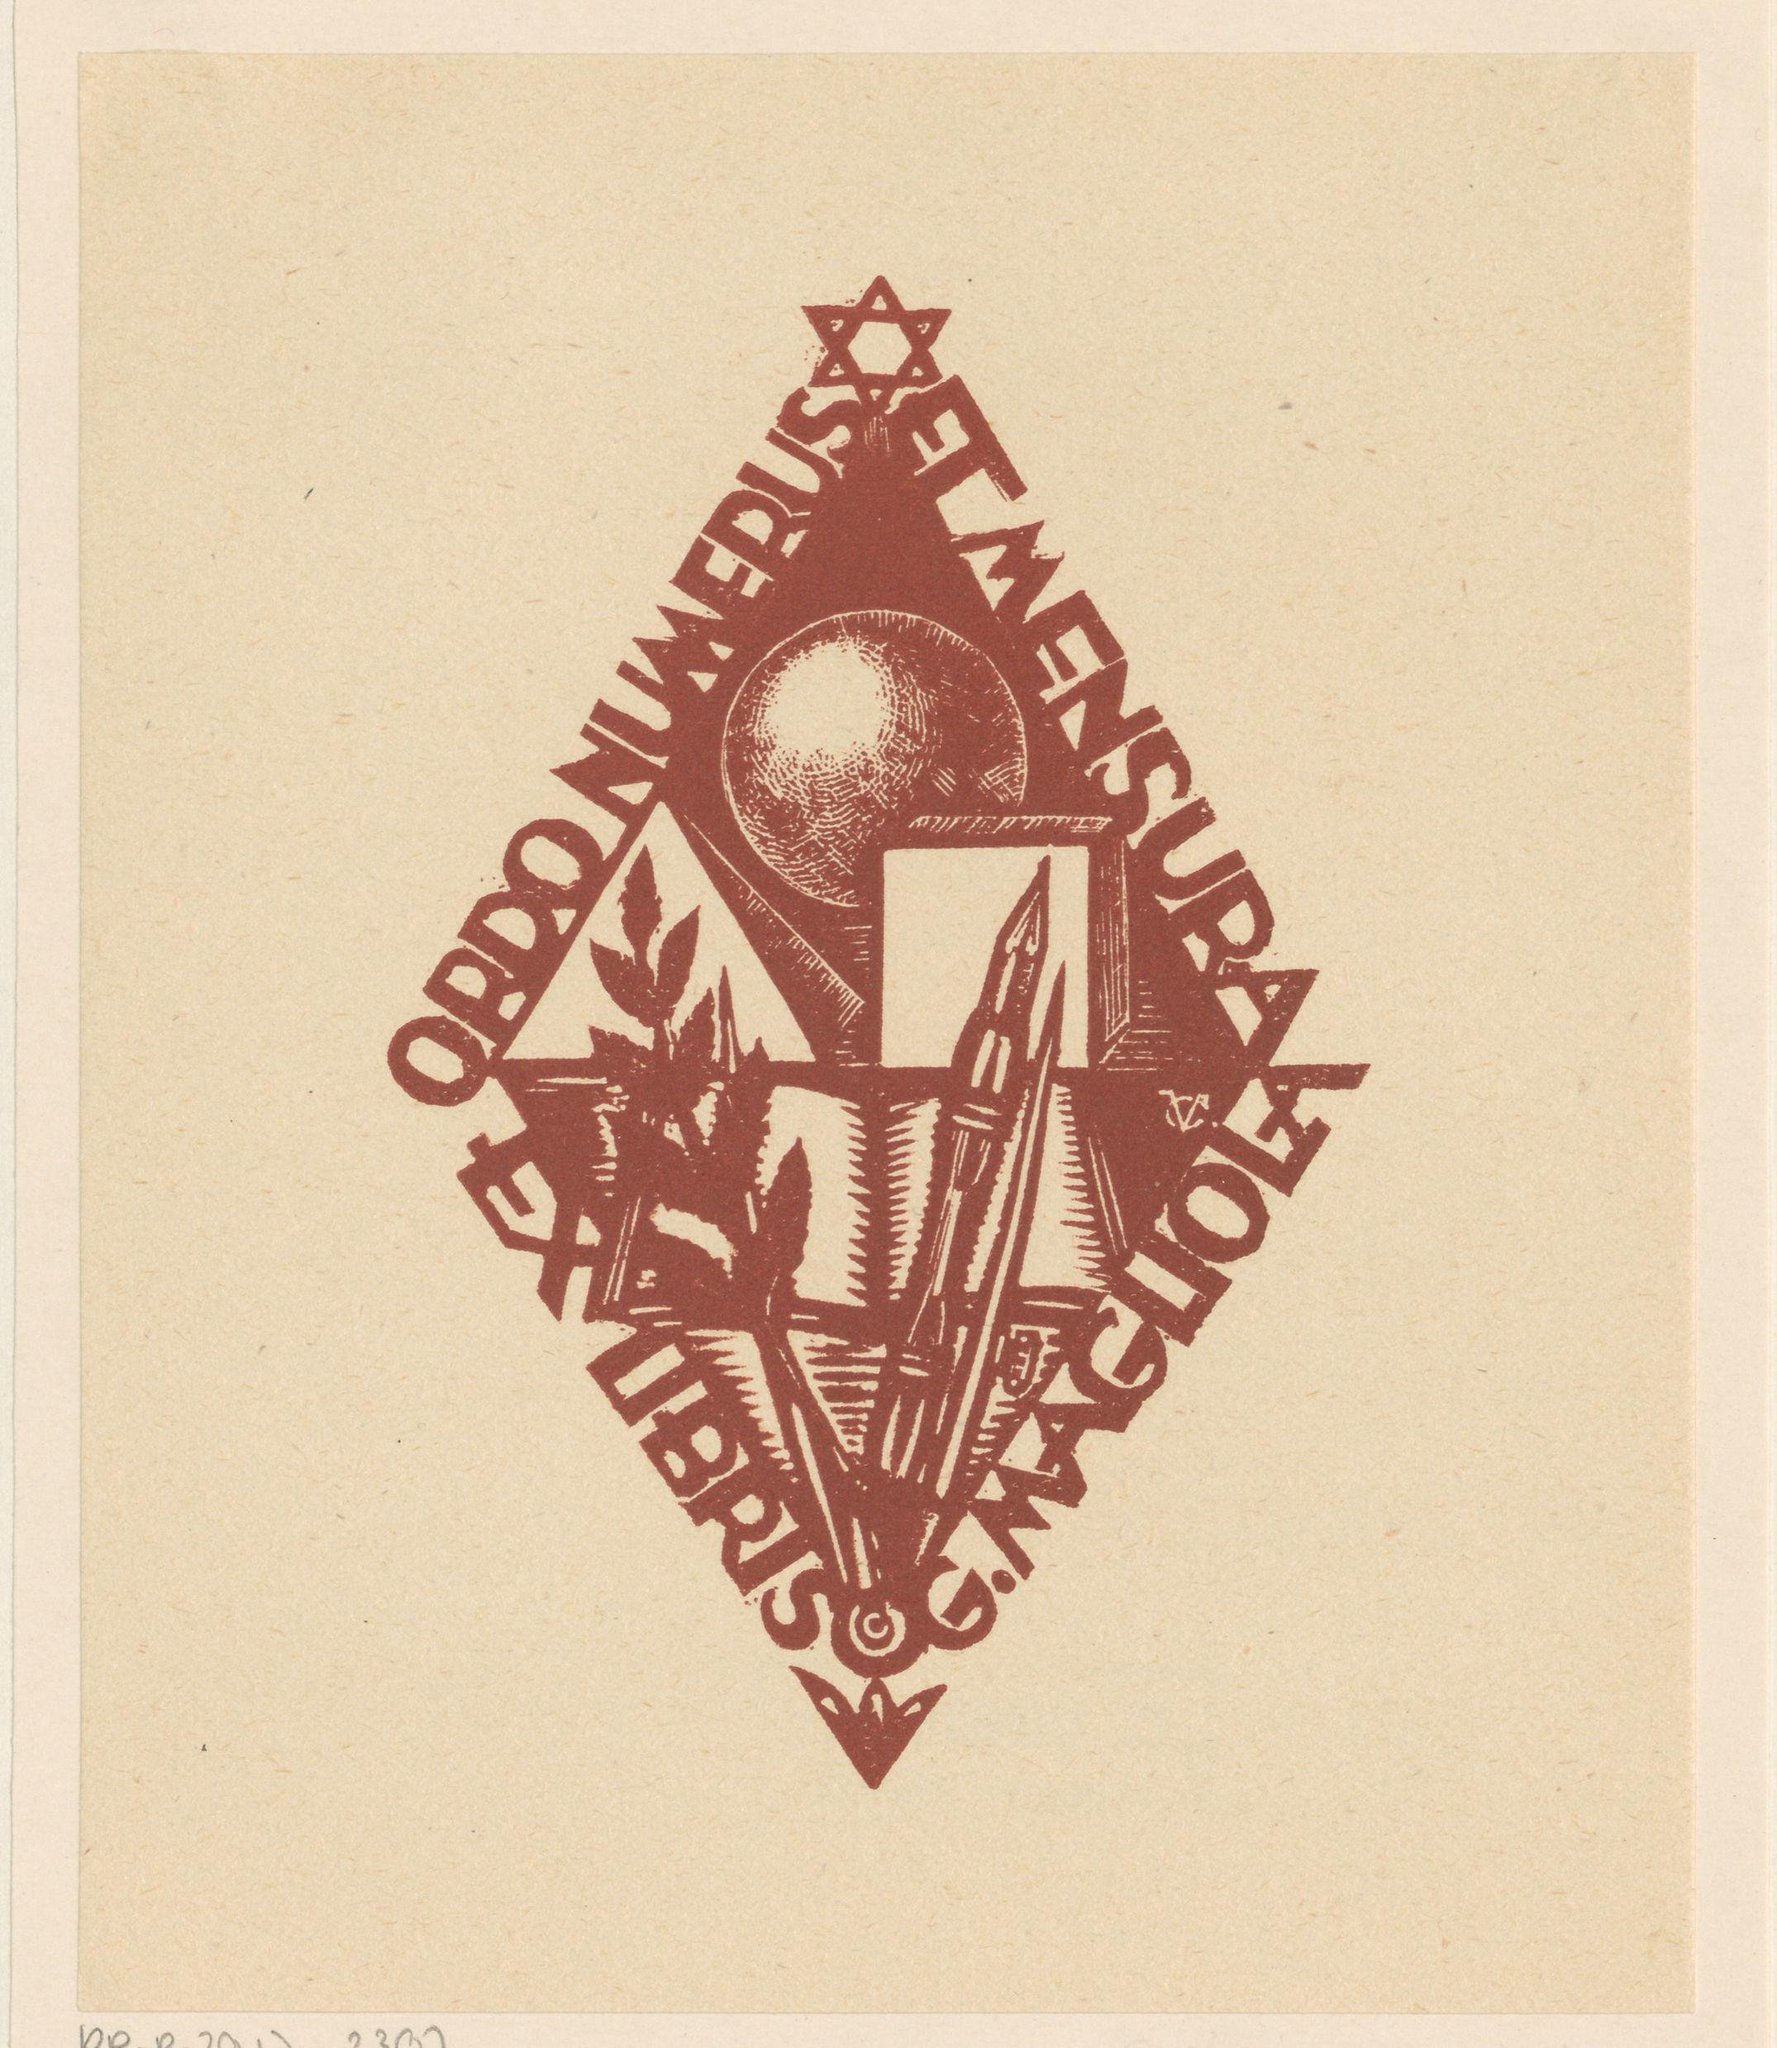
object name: bookplate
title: Ex libris van G. Magliola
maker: cesare vincenti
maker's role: print maker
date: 1946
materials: paper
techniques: woodcut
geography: italy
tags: giovanni magliola, sphere, globe ~ stereometry, pyramid ~ stereometry, book, tools, implements of draughtsman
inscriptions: workshop stamp: ‘C. Vincenti / xilogr 1946’